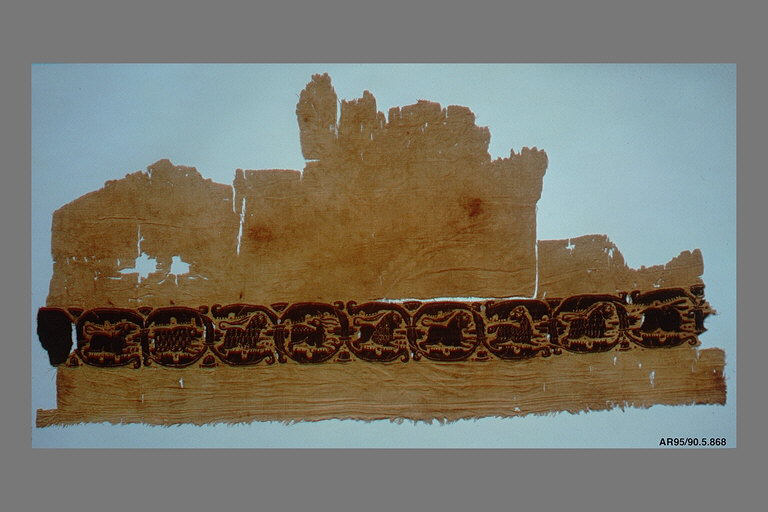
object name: textile fragment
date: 201-400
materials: linen, wool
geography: egypt